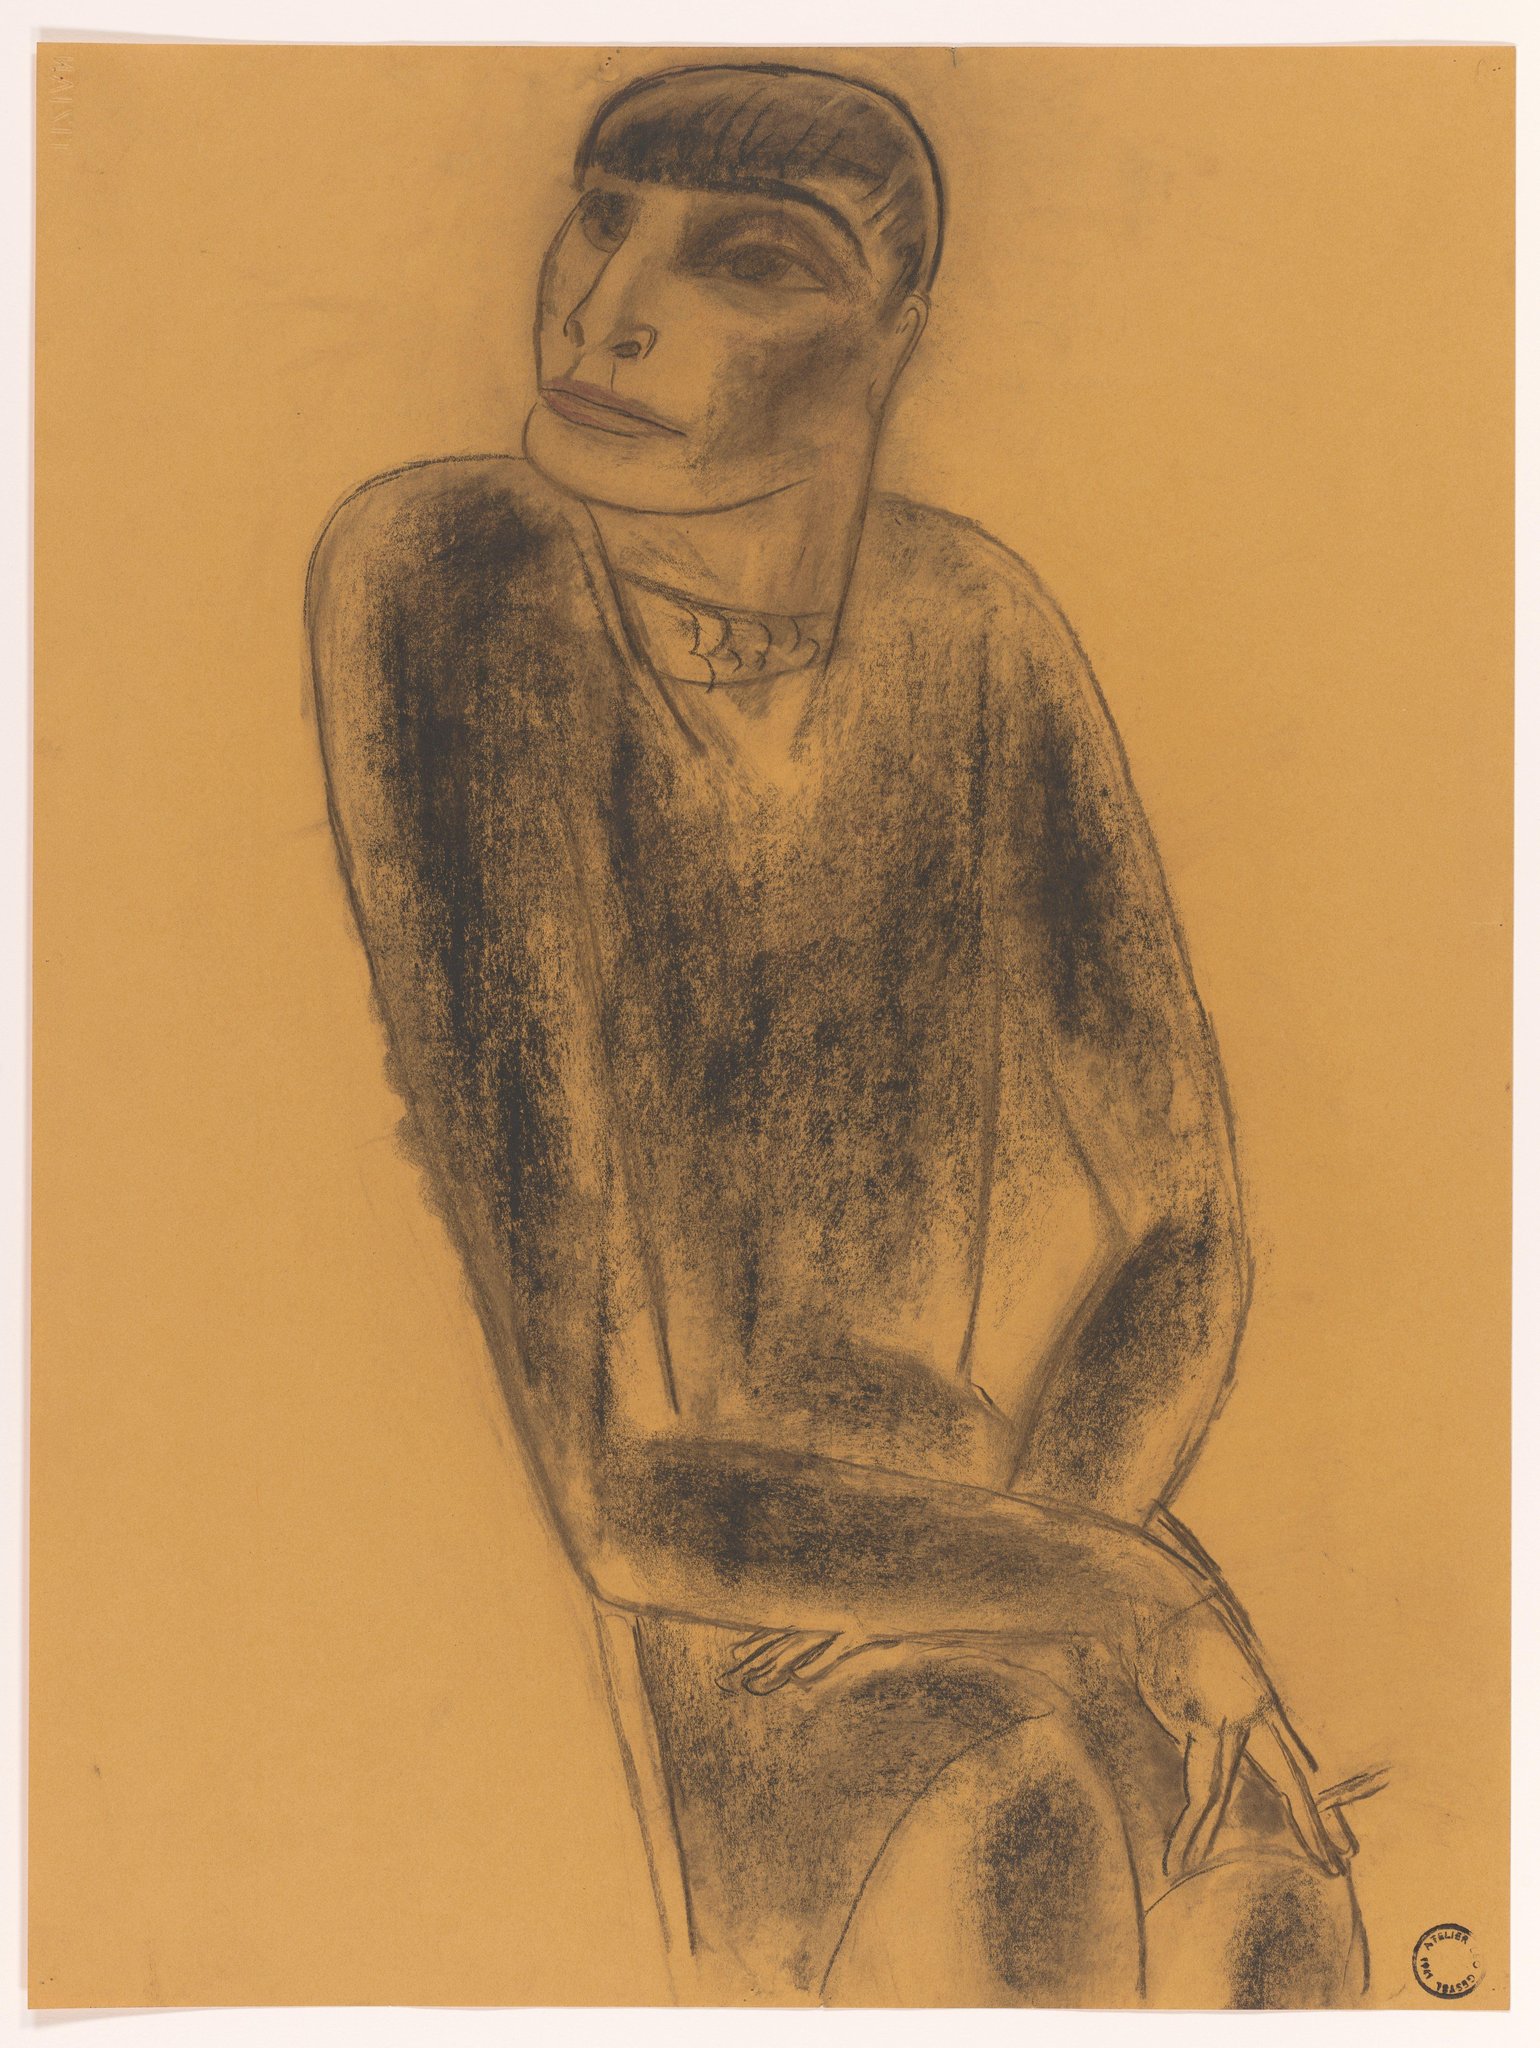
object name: drawing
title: Rokende vrouw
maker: leo gestel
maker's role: draughtsman, print maker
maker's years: 1881-1941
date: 1930-1931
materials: chalk, charcoal, paper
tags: adult woman, cigarette-case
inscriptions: workshop stamp: Lugt 1078a, date: ‘1930-31’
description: Zittende rokende vrouw, tot op de knieën weergegeven.